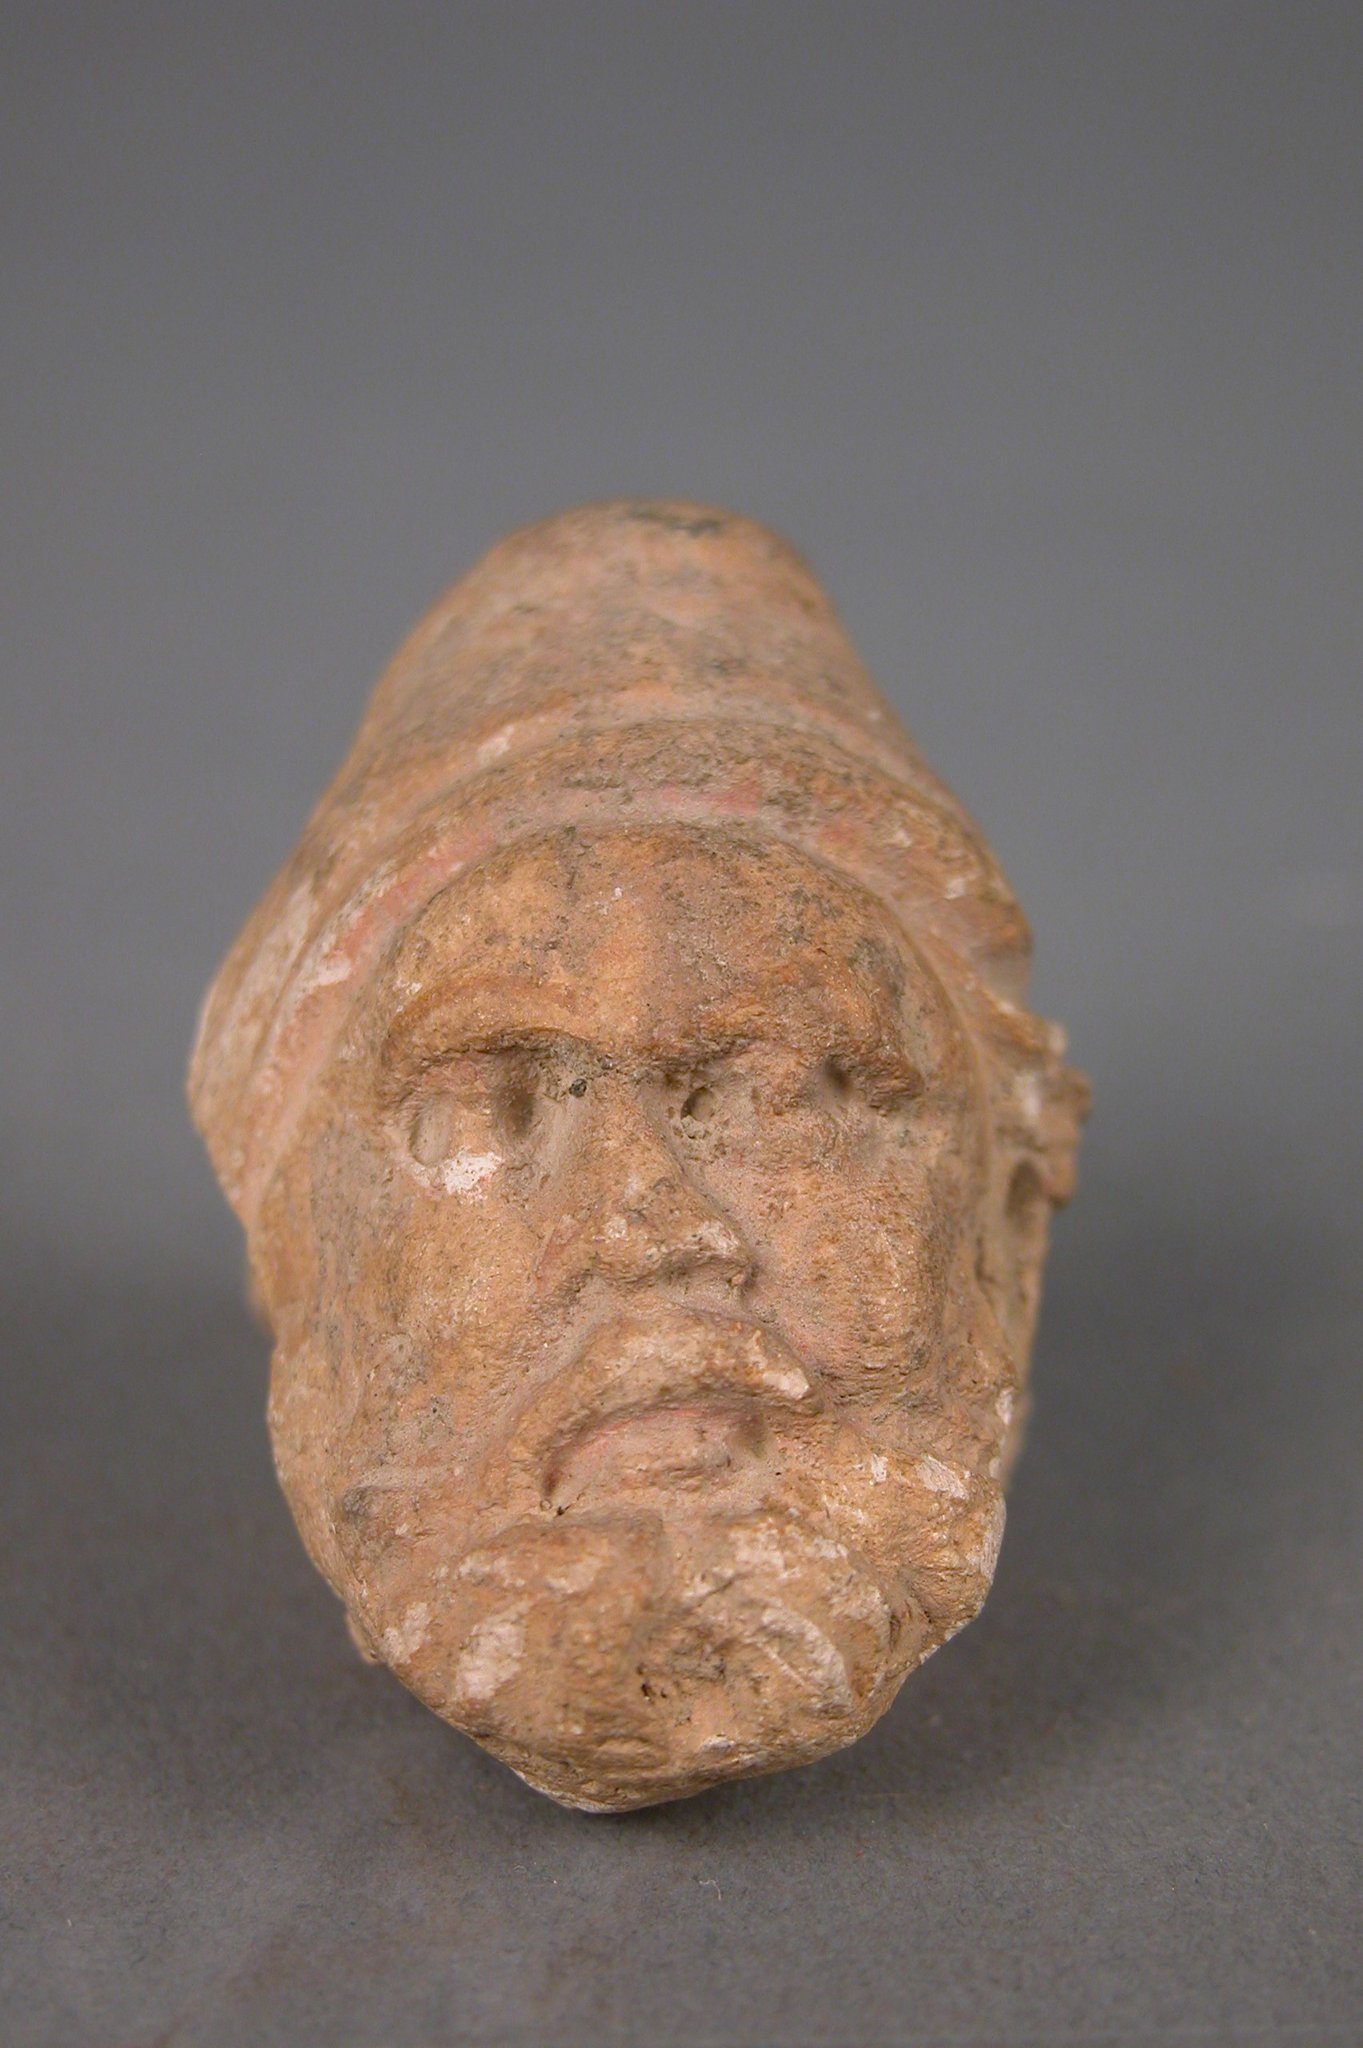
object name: wall decoration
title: Head of an Iranian Nomad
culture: gandhara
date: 201-500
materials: plaster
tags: gandhara,heads